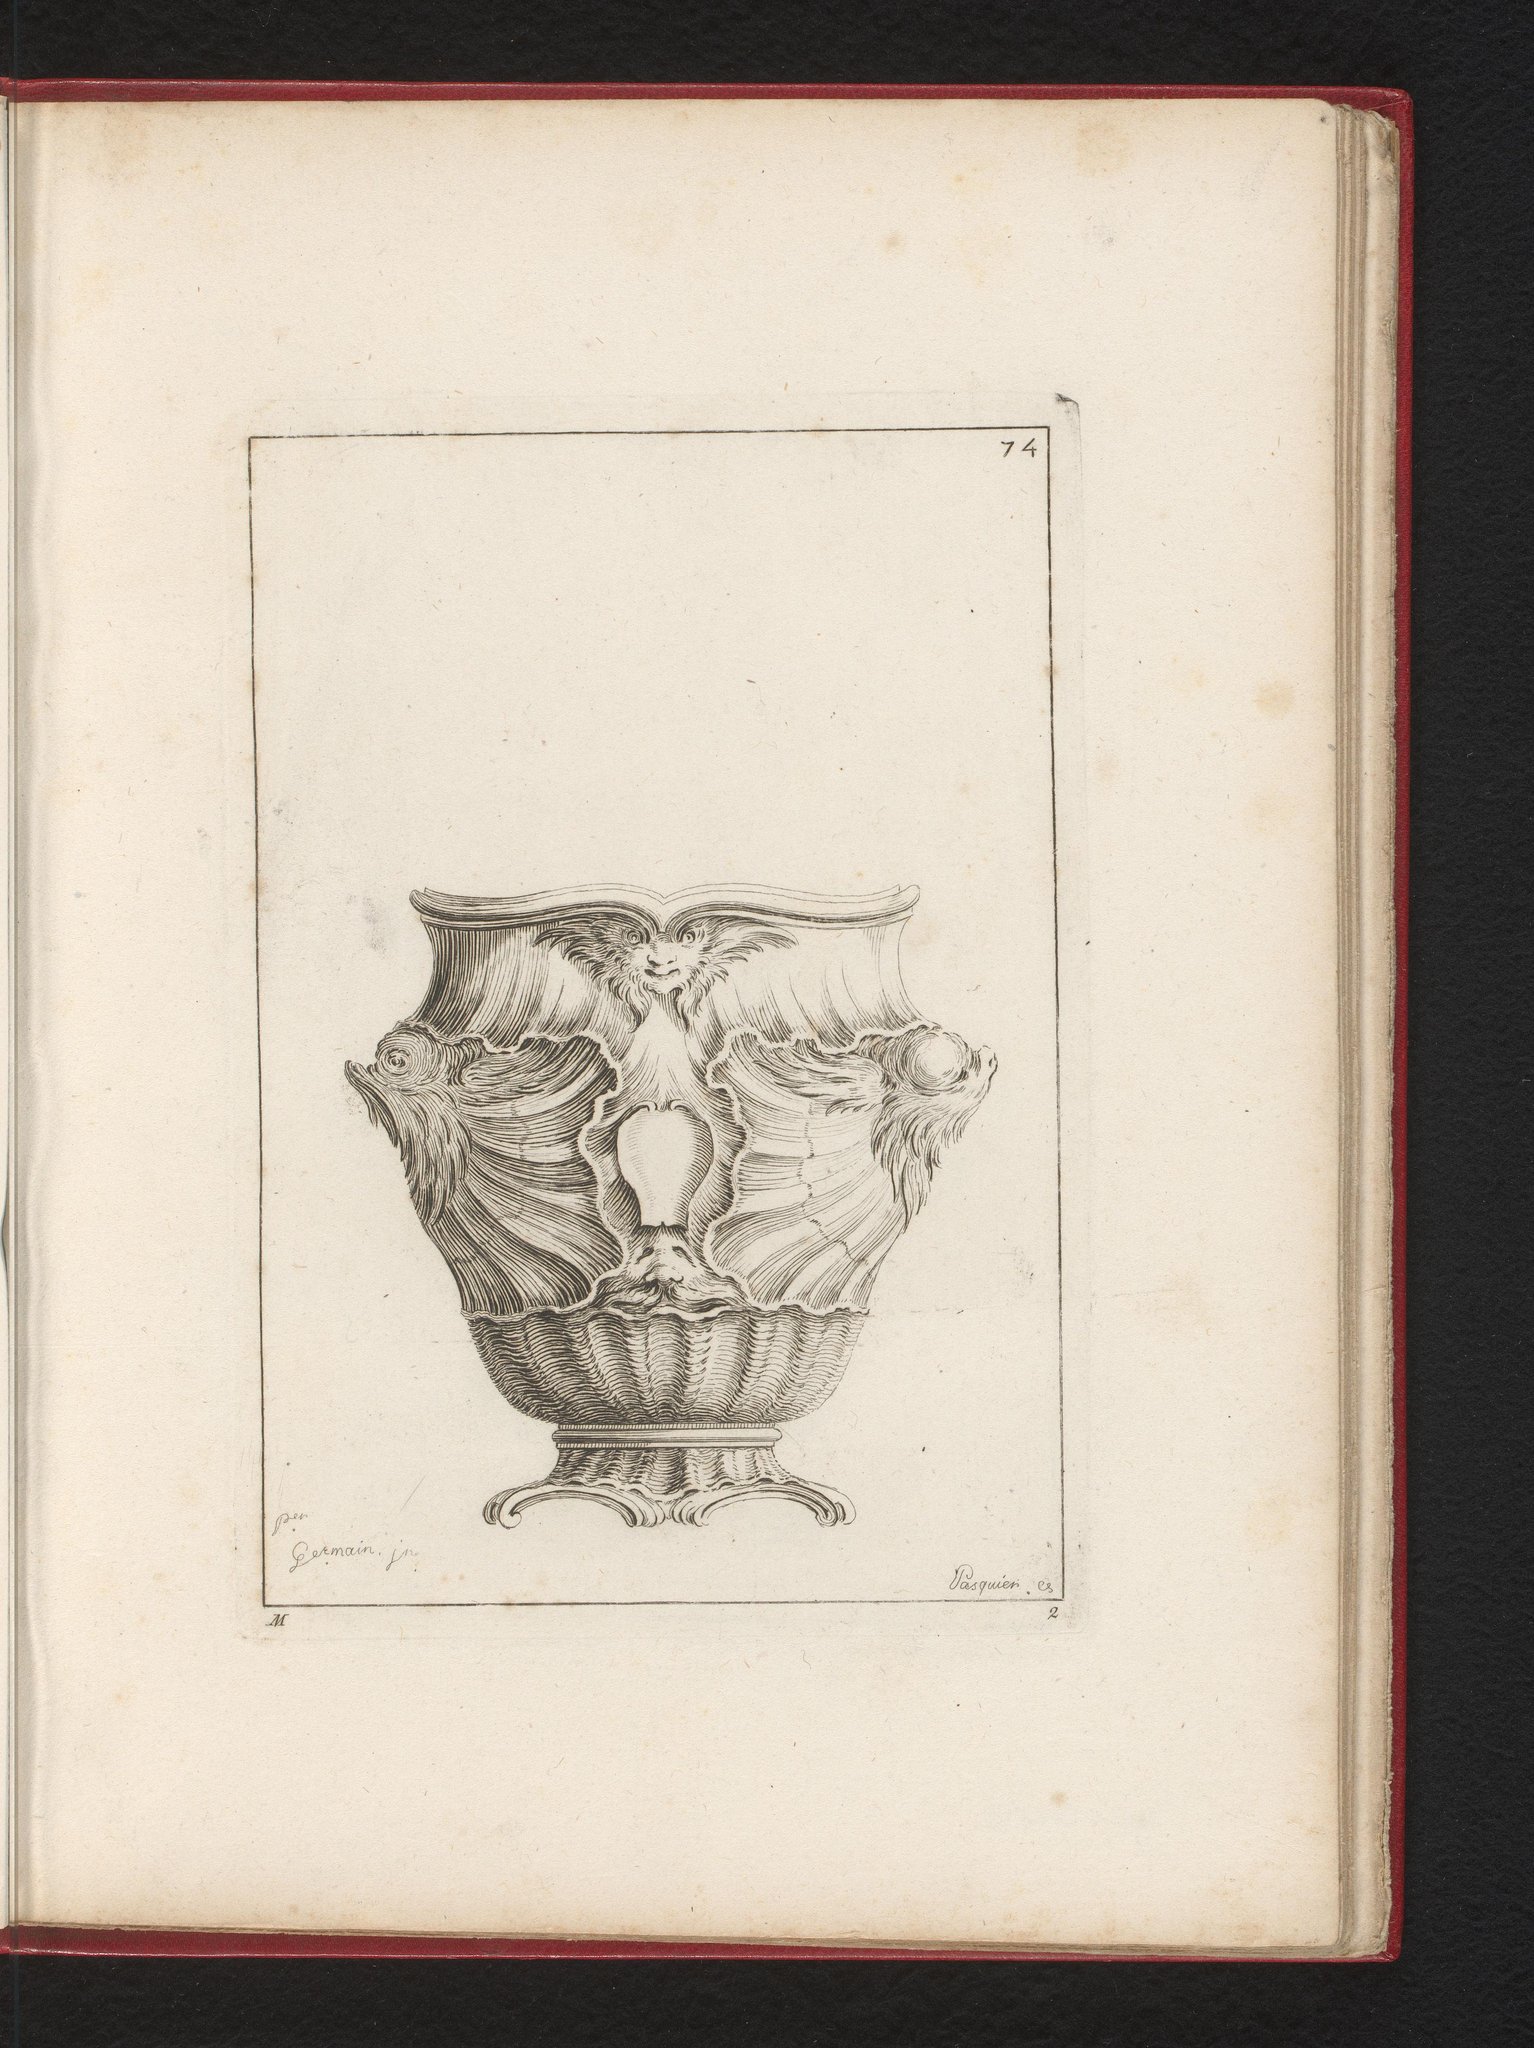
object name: print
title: Elements d'orfevrerie divisés en deux parties de cinquante feuilles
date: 1748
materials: paper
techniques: etching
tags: wine-cooler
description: Een aantal van de objecten in deze reeks heeft een eigen ondertitel, die verwijst naar genummerde 'cahiers' (afleveringen) waarin de prenten werden uitgegeven. Het is onduidelijk welke objecten recies bij welke aflevering horen. Daarom is die ondertitel enkel verwerkt bij de prent waarop die voorkomt.